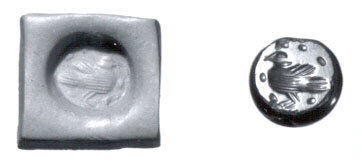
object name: stamp seal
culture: sasanian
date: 201-700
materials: jasper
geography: iran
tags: birds